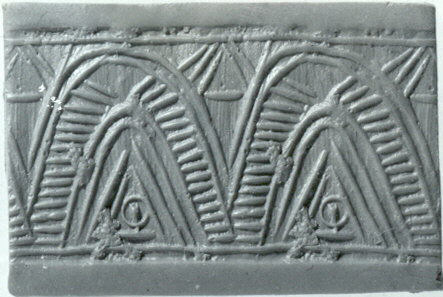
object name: cylinder seal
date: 3100-2900 BCE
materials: glaze, stone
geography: mesopotamia